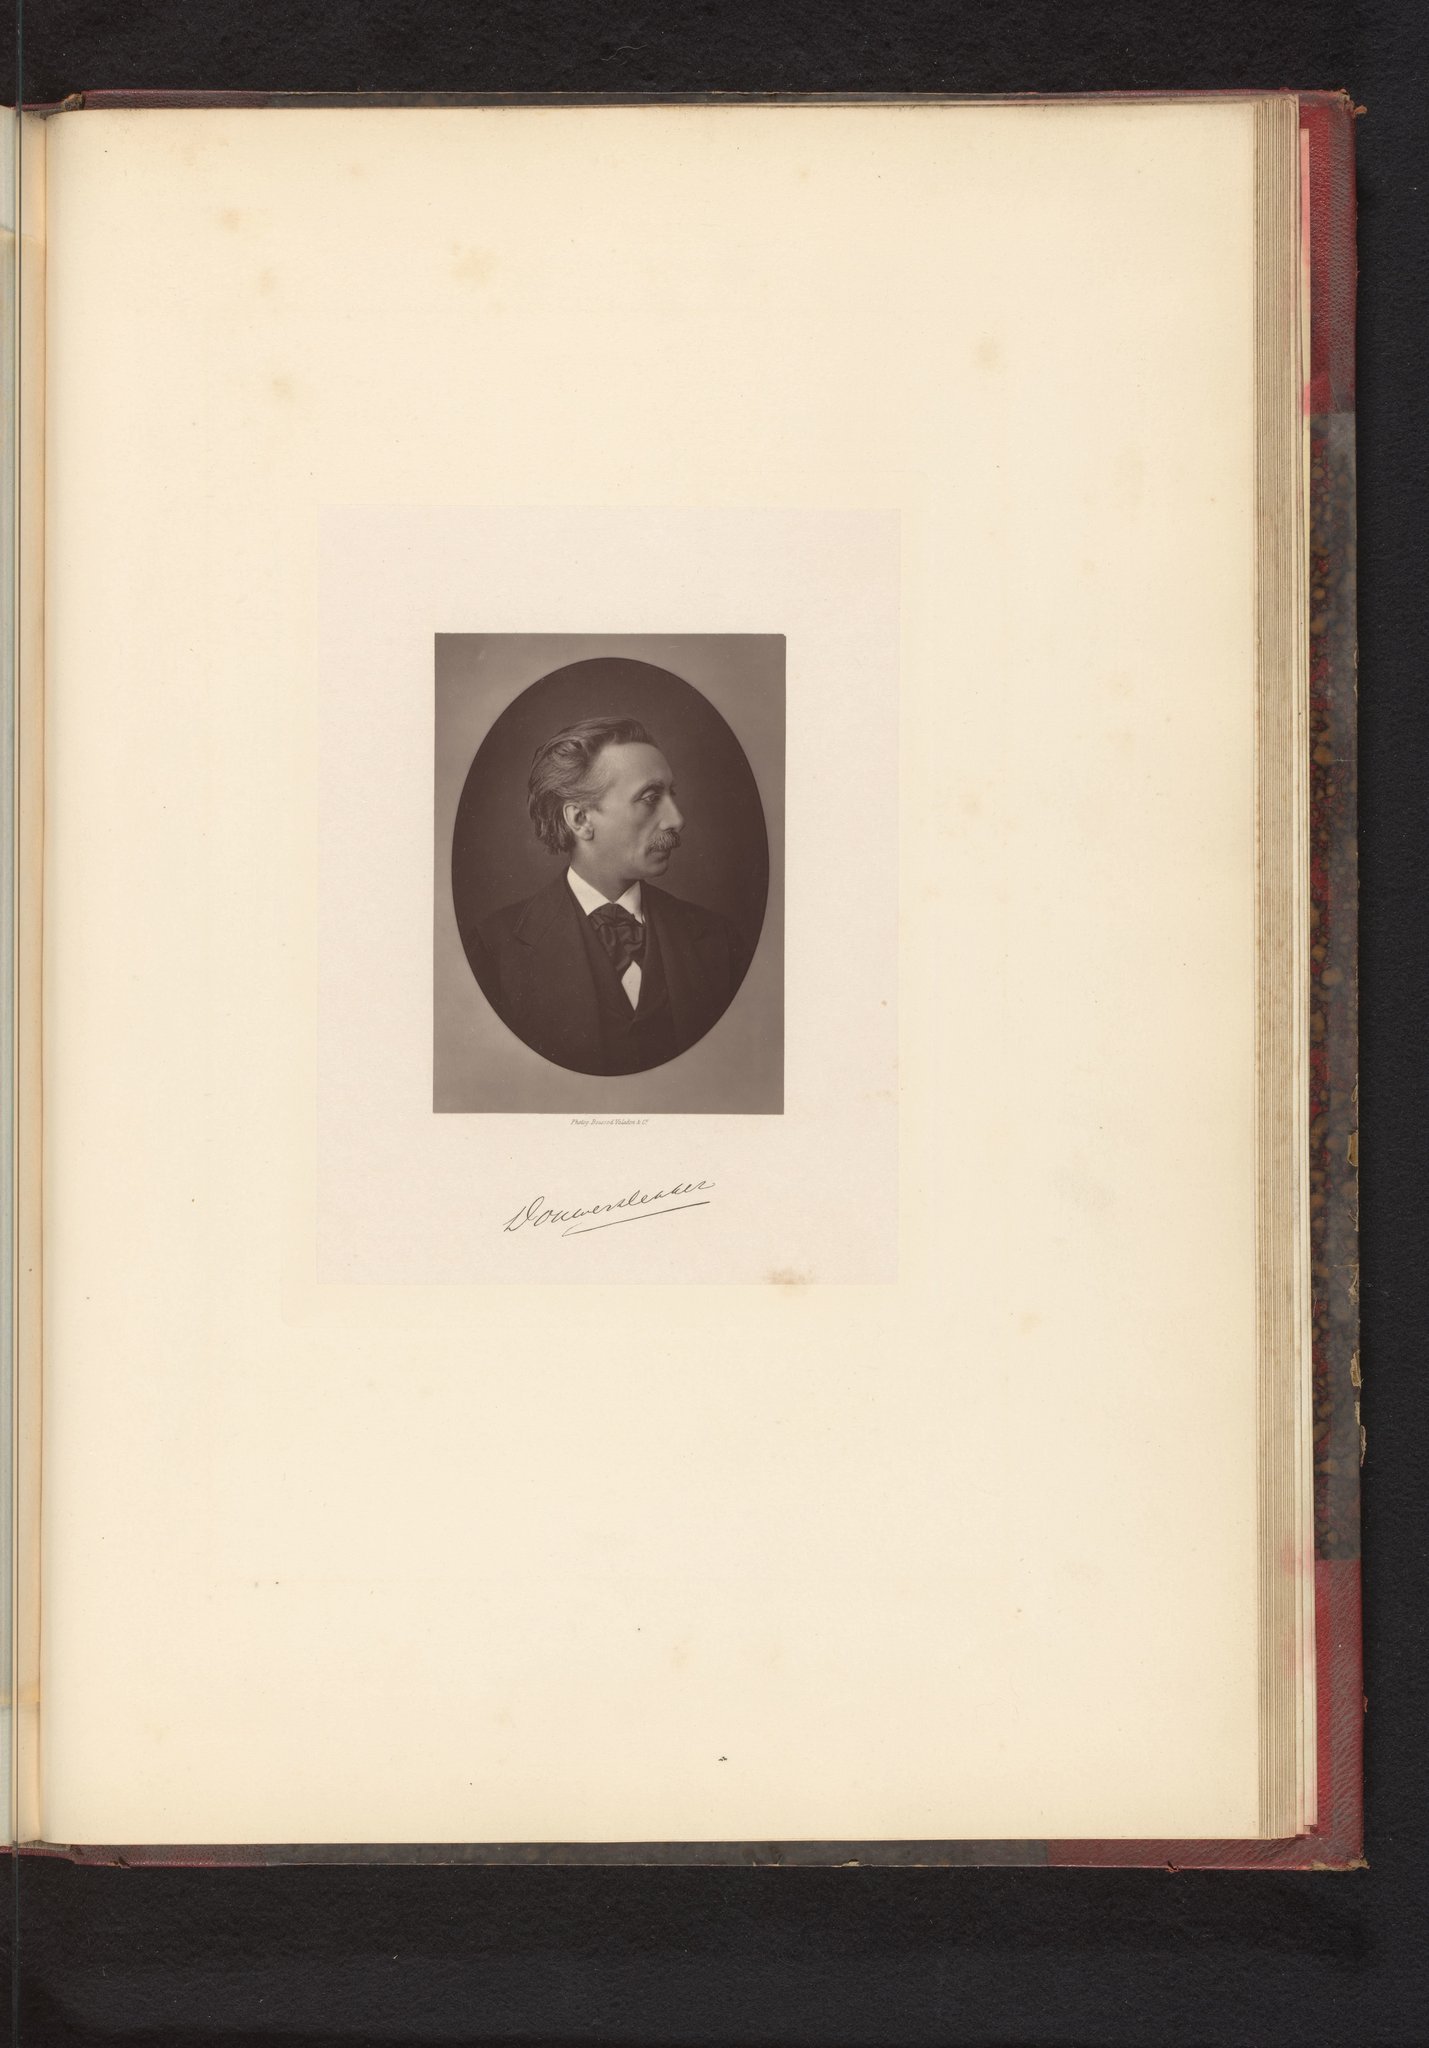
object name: photomechanical print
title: Portret van Multatuli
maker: Anonymous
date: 1878-1887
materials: paper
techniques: woodburytype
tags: amsterdam, multatuli, historical persons, writer, poet, author